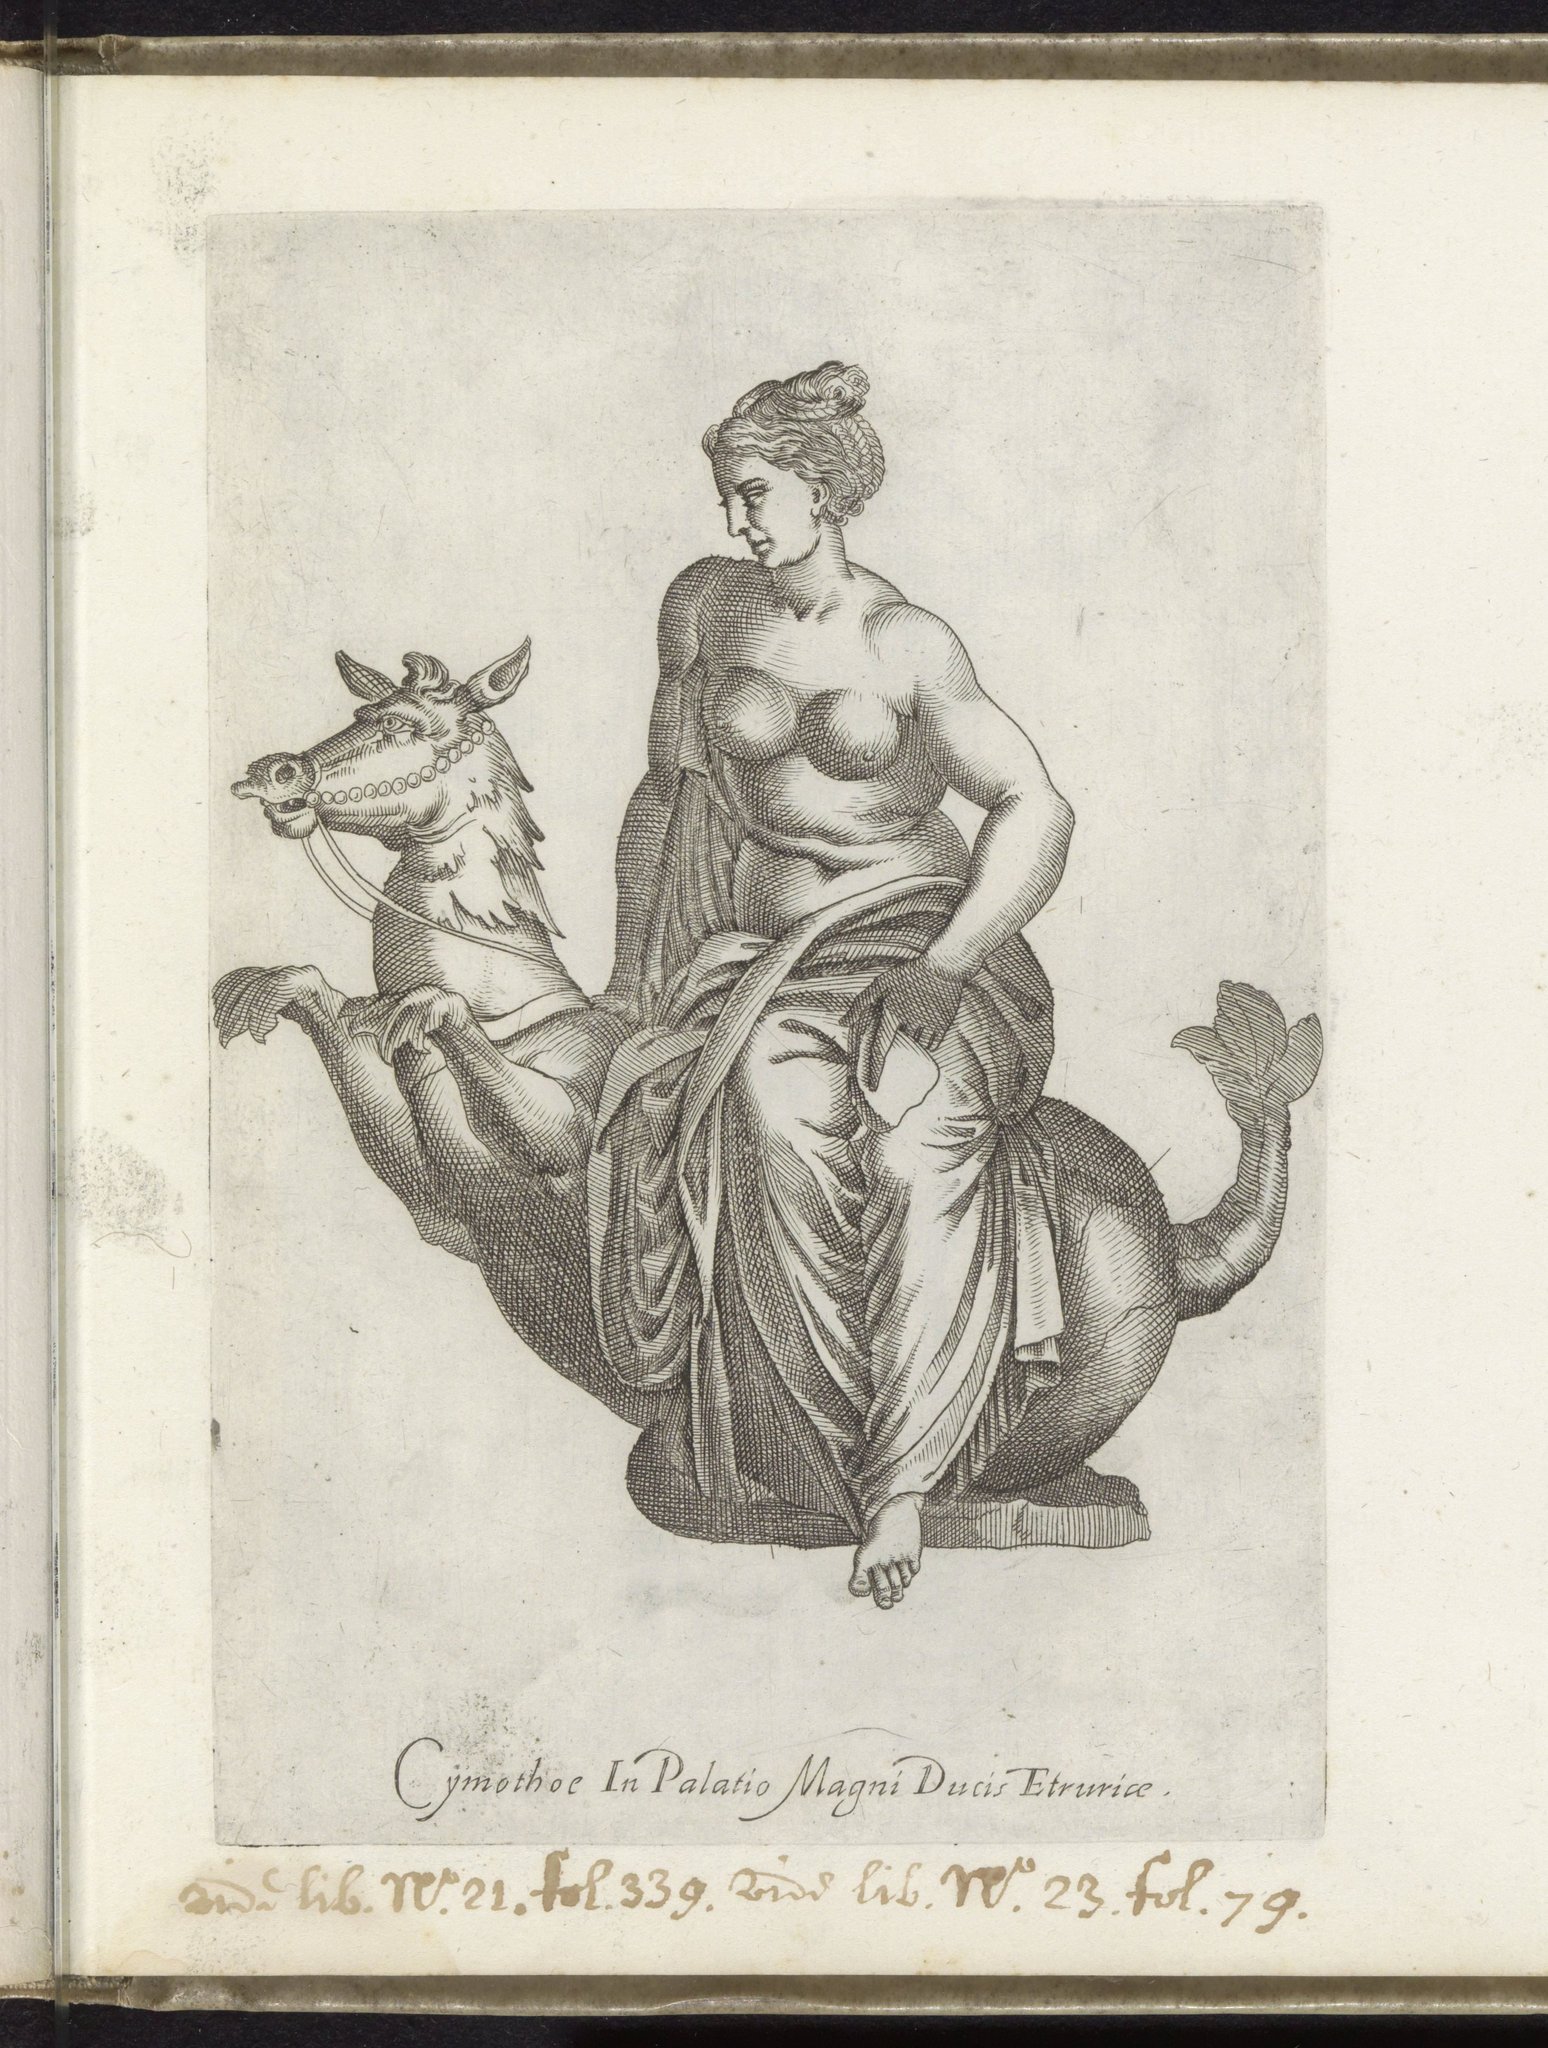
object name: album leaf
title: Sculptuur van de Nereïde Cymothoe rijdend op een zeewezen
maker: Anonymous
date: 1600-1699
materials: paper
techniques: engraving, etching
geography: italy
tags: nereids, daughters of nereus; sea-nymphs, piece of sculpture, reproduction of a piece of sculpture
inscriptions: inscription: ‘Ende lib. No. 21. fol. 339. Ende lib. No. 23. fol. 79.’, number: ‘81’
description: Deze prent maakt deel uit van een reeks van ten minste 50 prenten van sculpturen uit de oudheid.